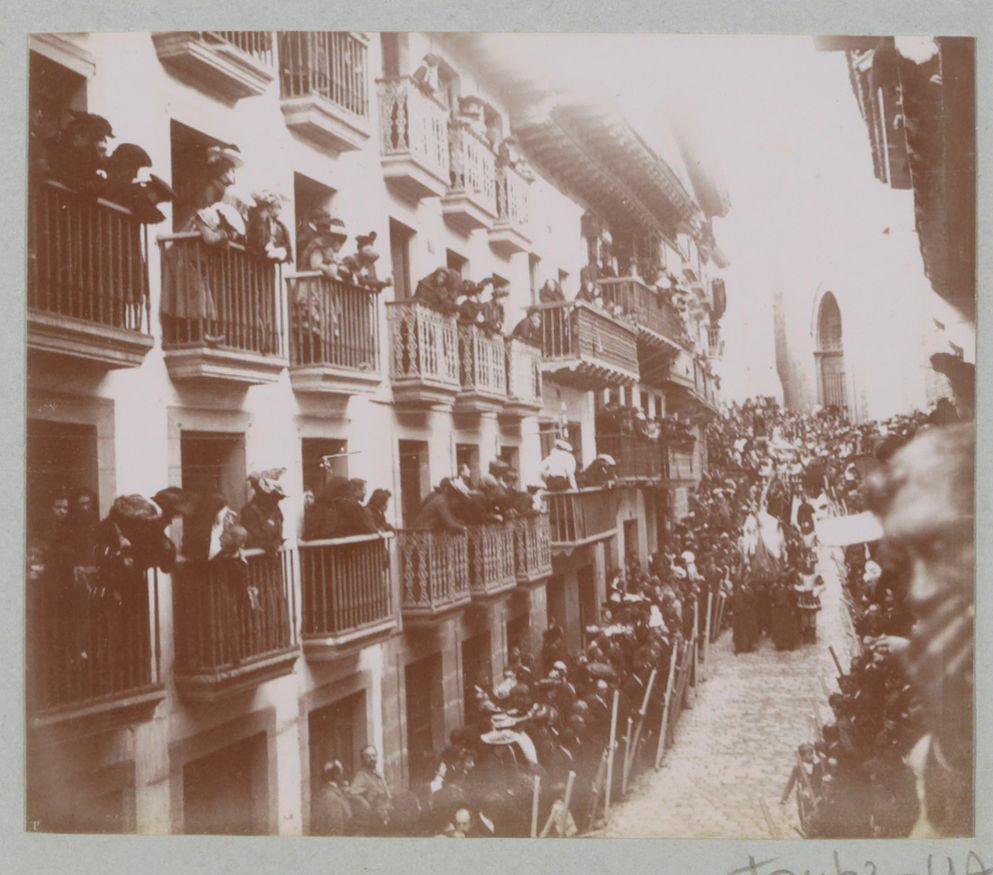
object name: photograph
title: Straatprocessie in Fontarrabie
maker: delizy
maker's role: manufacturer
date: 1904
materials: paper, photographic support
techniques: gelatin silver print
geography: fontarrabie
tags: procession ~ christian religion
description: Onderdeel van Fotoalbum van een Franse amateurfotograaf met opnames van uitstapjes in Frankrijk, Spanje, België, Luxemburg en Nederland, de eerste automobielen en autoraces.